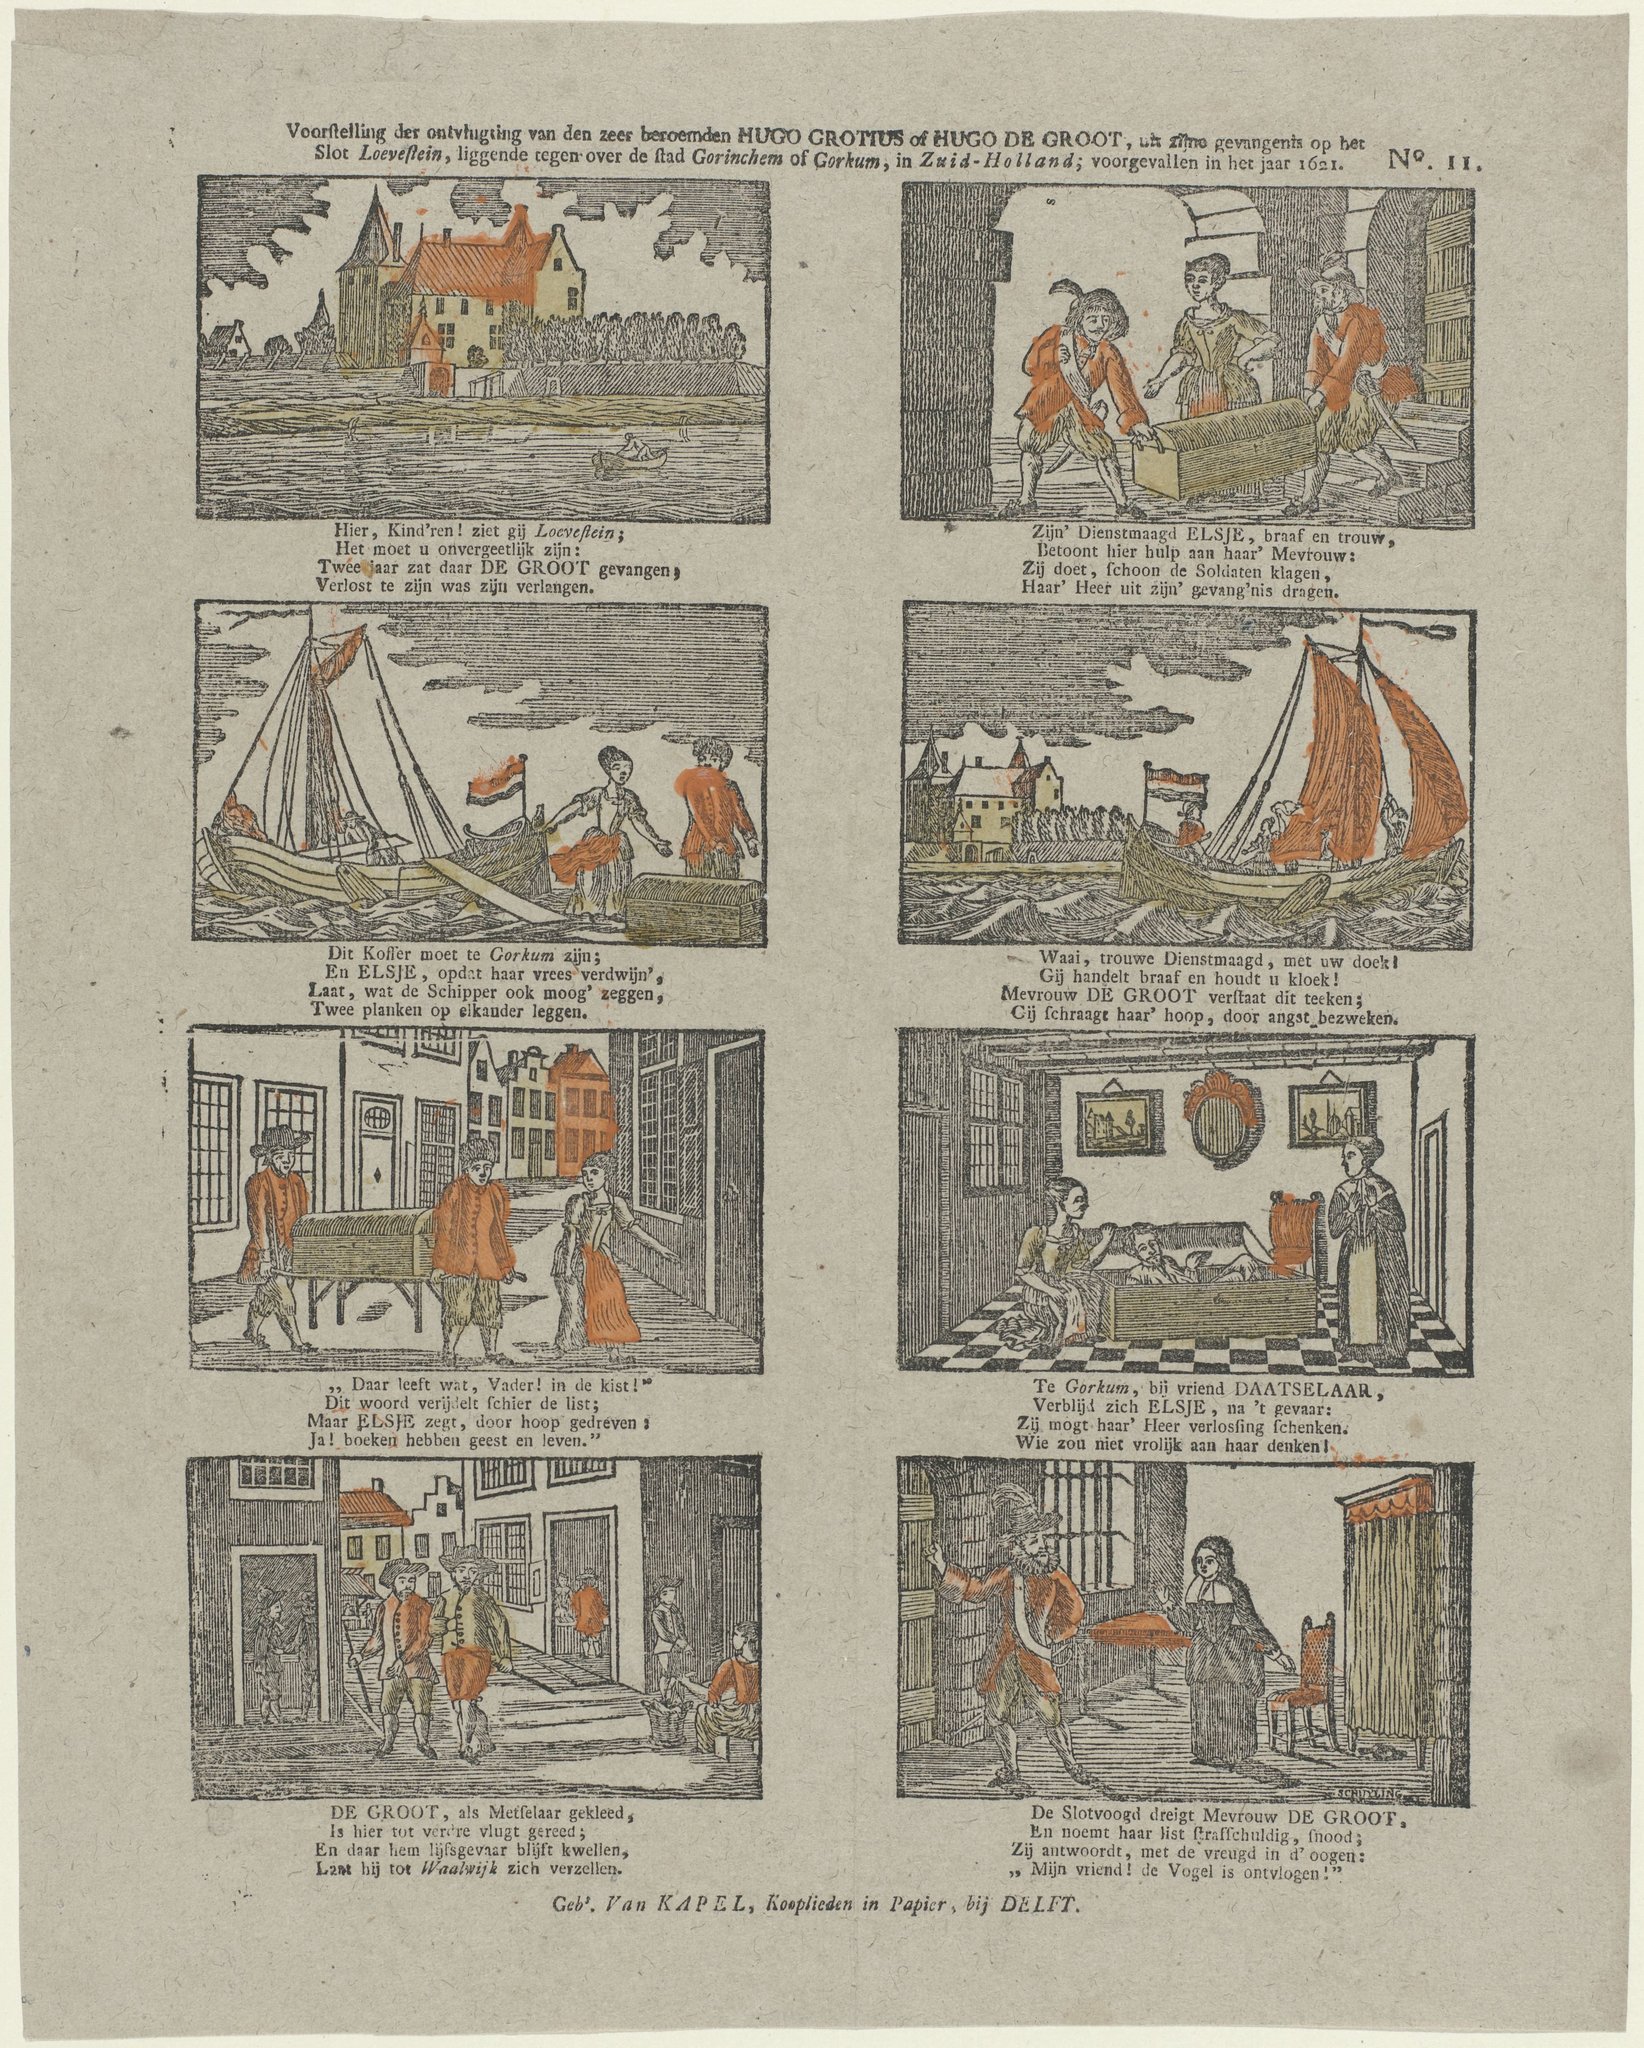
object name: popular print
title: Voorstelling der ontvlugting van den zeer beroemden Hugo Grotius of Hugo de Groot (...)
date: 1820-1838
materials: paper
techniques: colour, letterpress printing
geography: amsterdam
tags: delft, hugo de groot, escape, escape attempts, loevestein castle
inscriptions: collector's mark: Lugt 2760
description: Blad met 8 voorstellingen over de ontsnapping van Hugo de Groot uit Slot Loevestein. Onder elke afbeelding een vierregelig vers. Genummerd rechtsboven: No. 11.